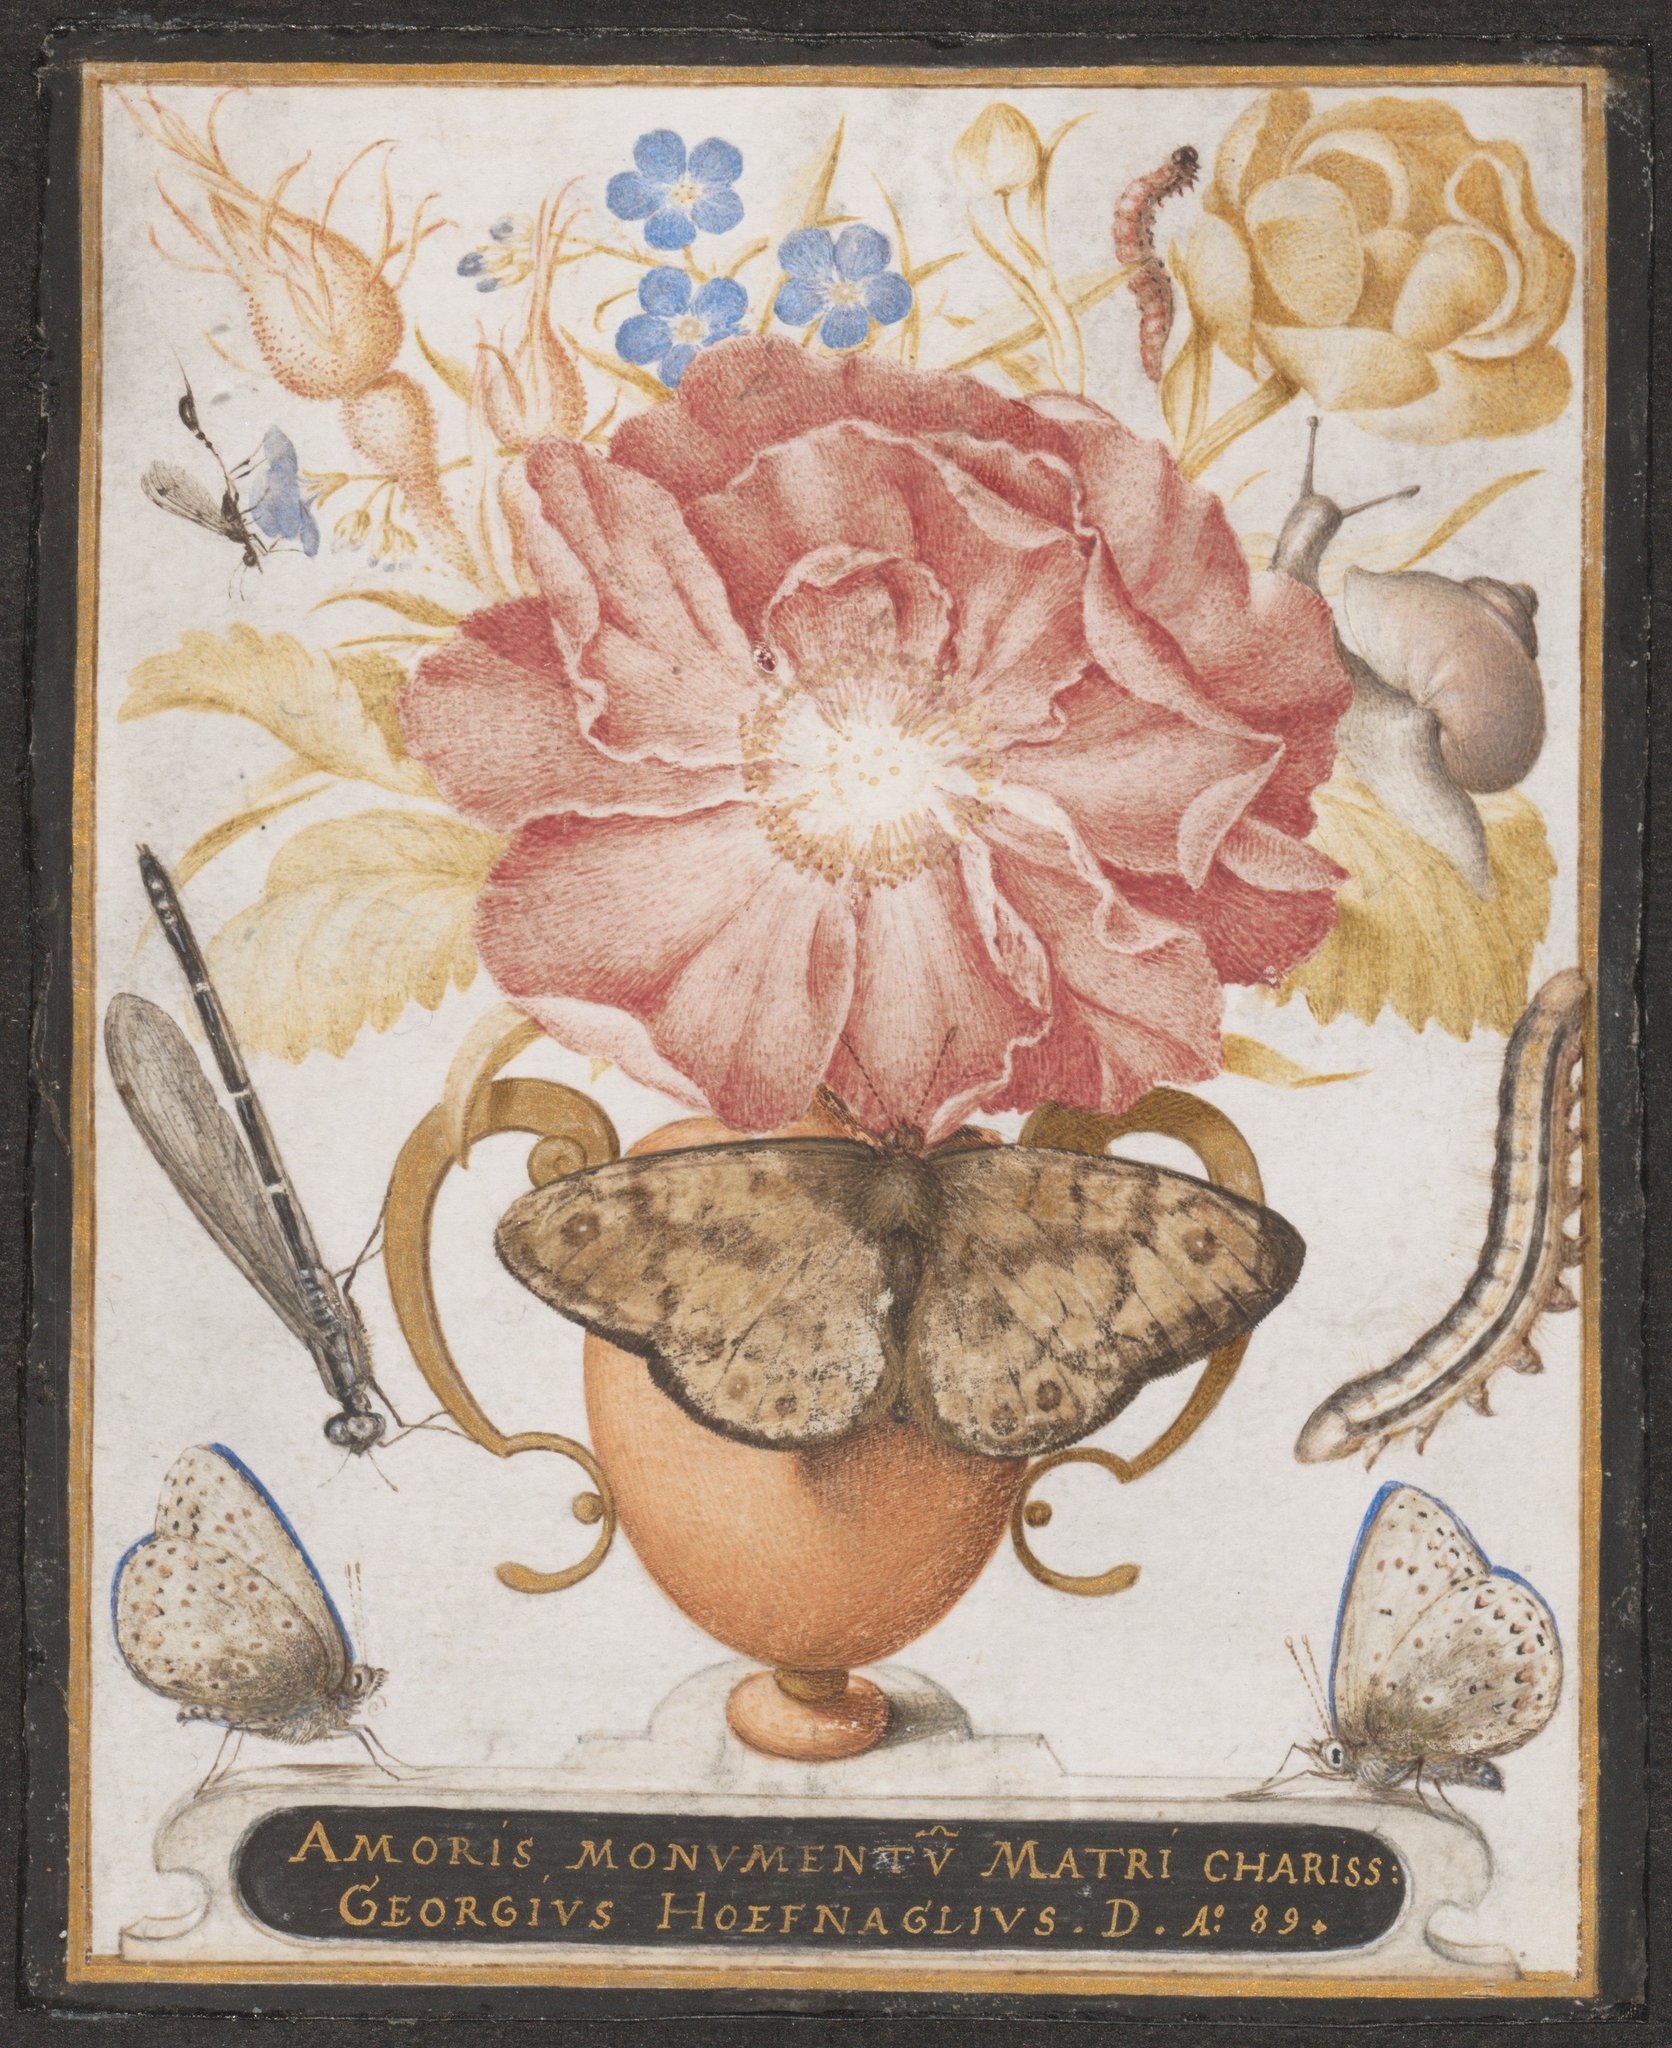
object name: drawing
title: Still Life with Flowers, a Snail and Insects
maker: joris hoefnagel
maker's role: artist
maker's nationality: netherlandish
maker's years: 1542-1600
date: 1589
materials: gold, gouache, shell, parchment, watercolor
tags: insects,butterflies,snails,flowers,still life